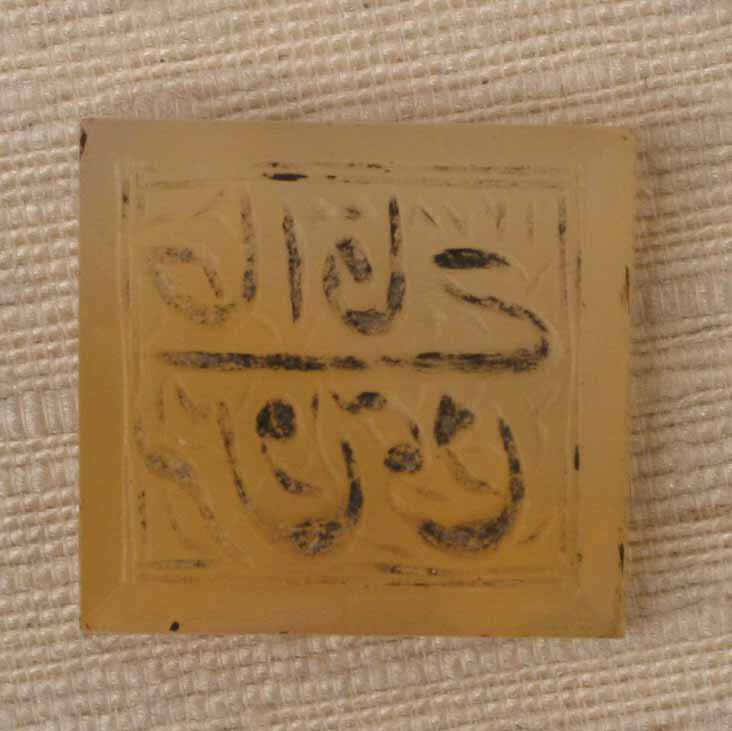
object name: stamp seal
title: Seal Stamp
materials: stone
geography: iran